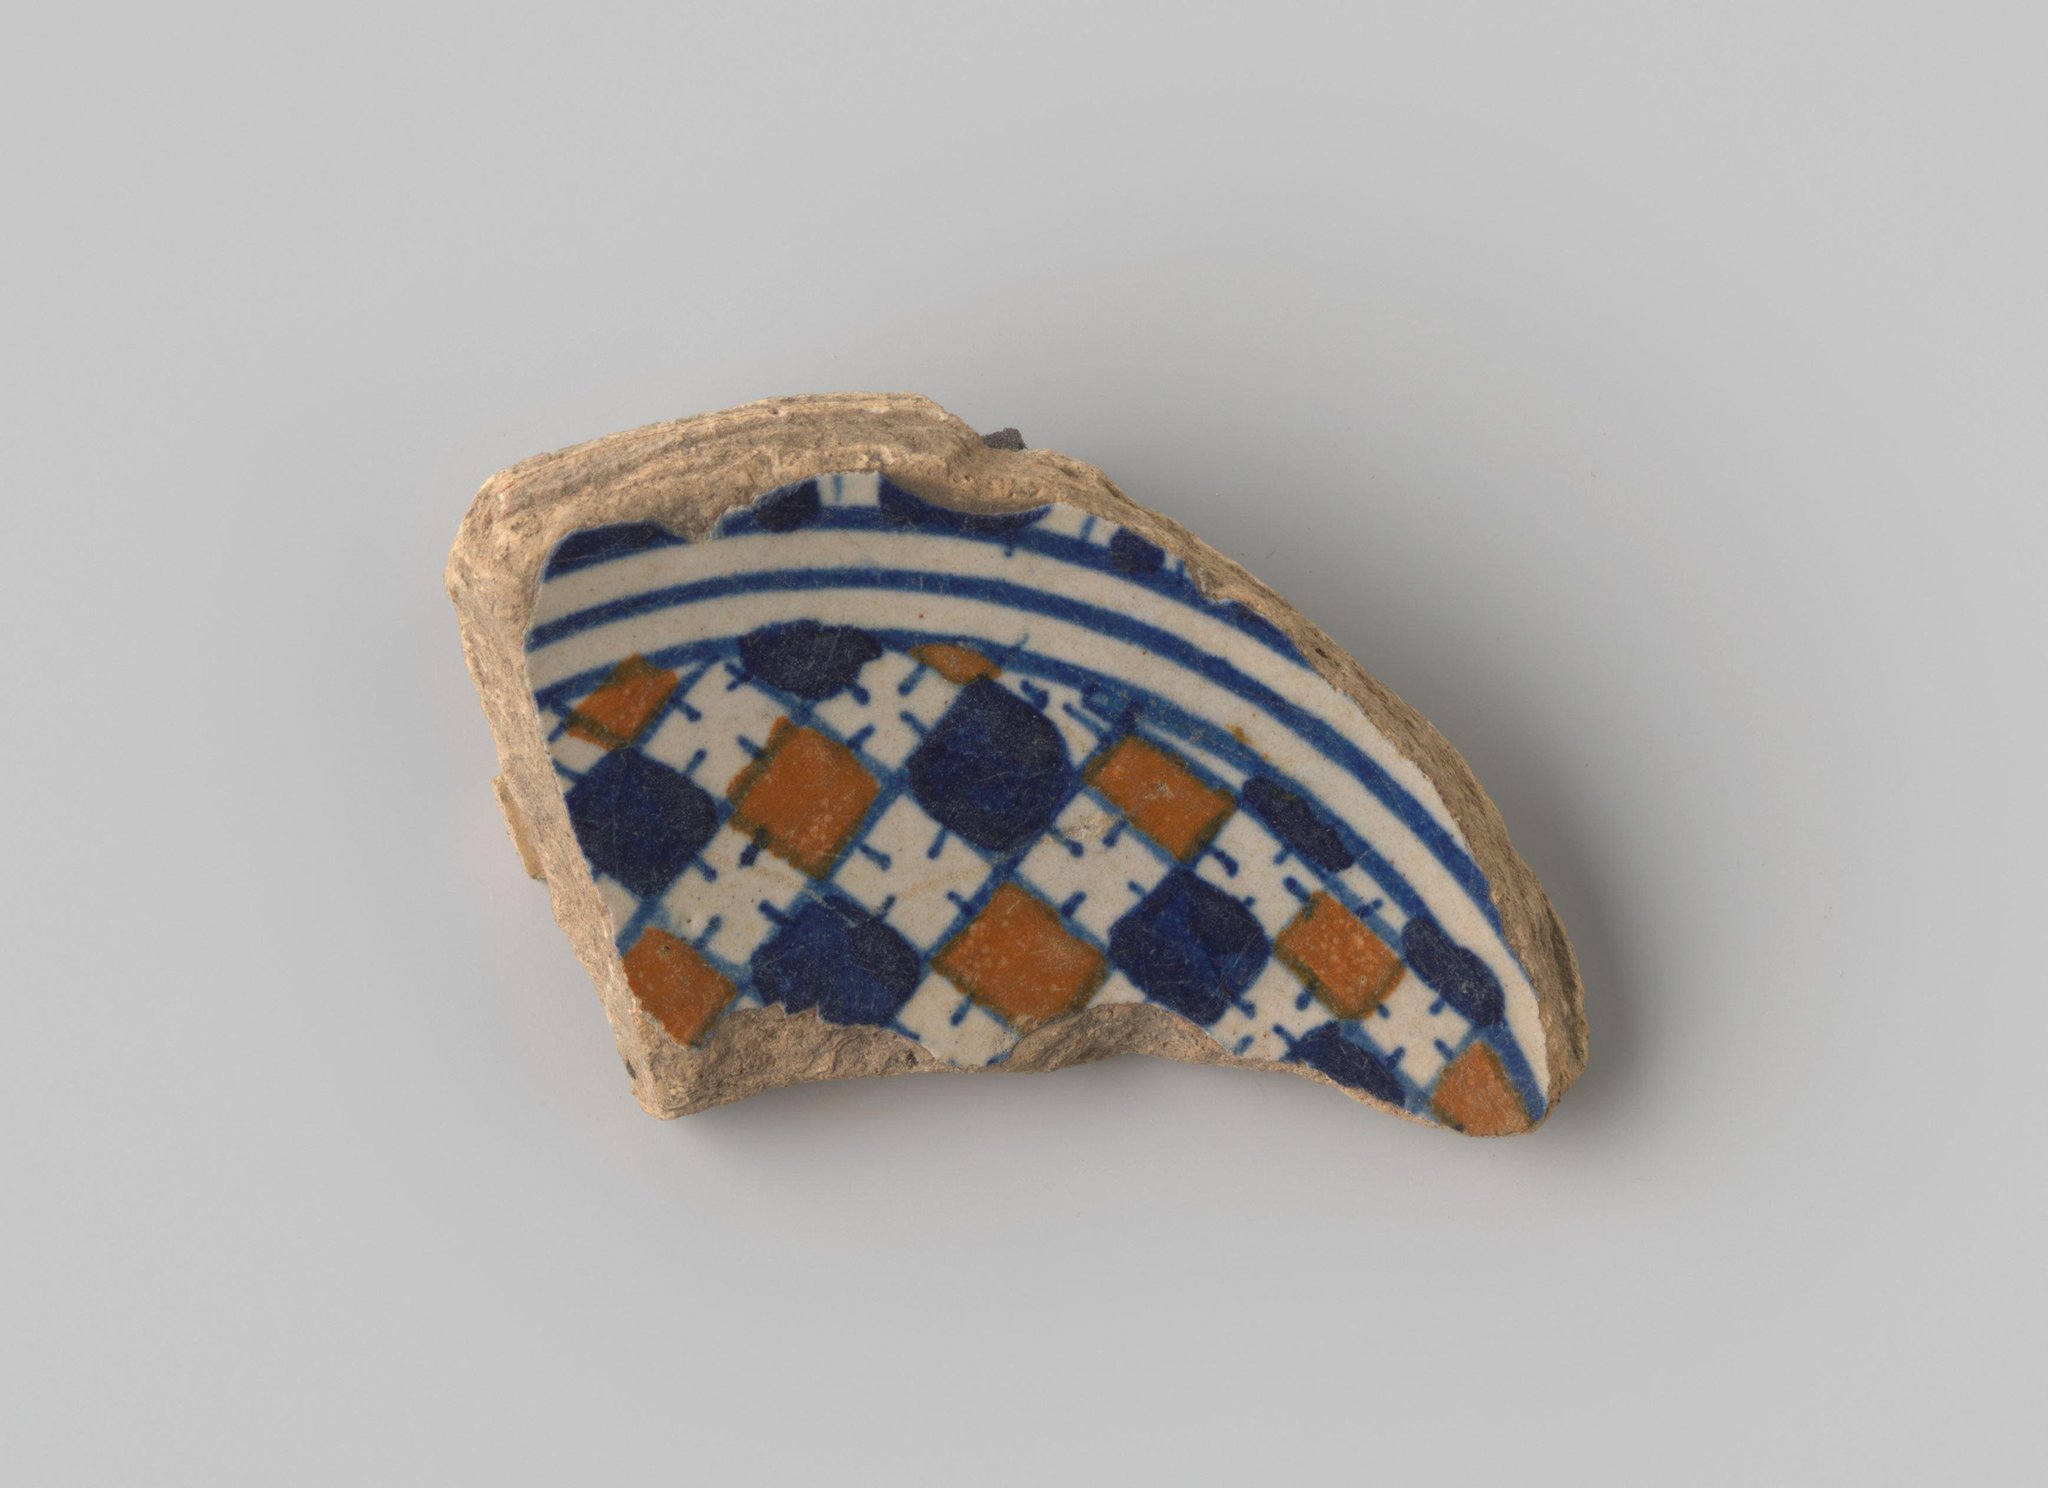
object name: fragment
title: Fragment van een schotel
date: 1500-1600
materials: earthenware, glaze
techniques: maiolica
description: Fragment van een schotel op een lage voetring. Crème scherf bedekt met tinglazuur aan de voorzijde en loodglazuur aan de achterzijde. Beschilderd in blauw en oranje met een schaakbordpatroon binnen blauwe cirkels.